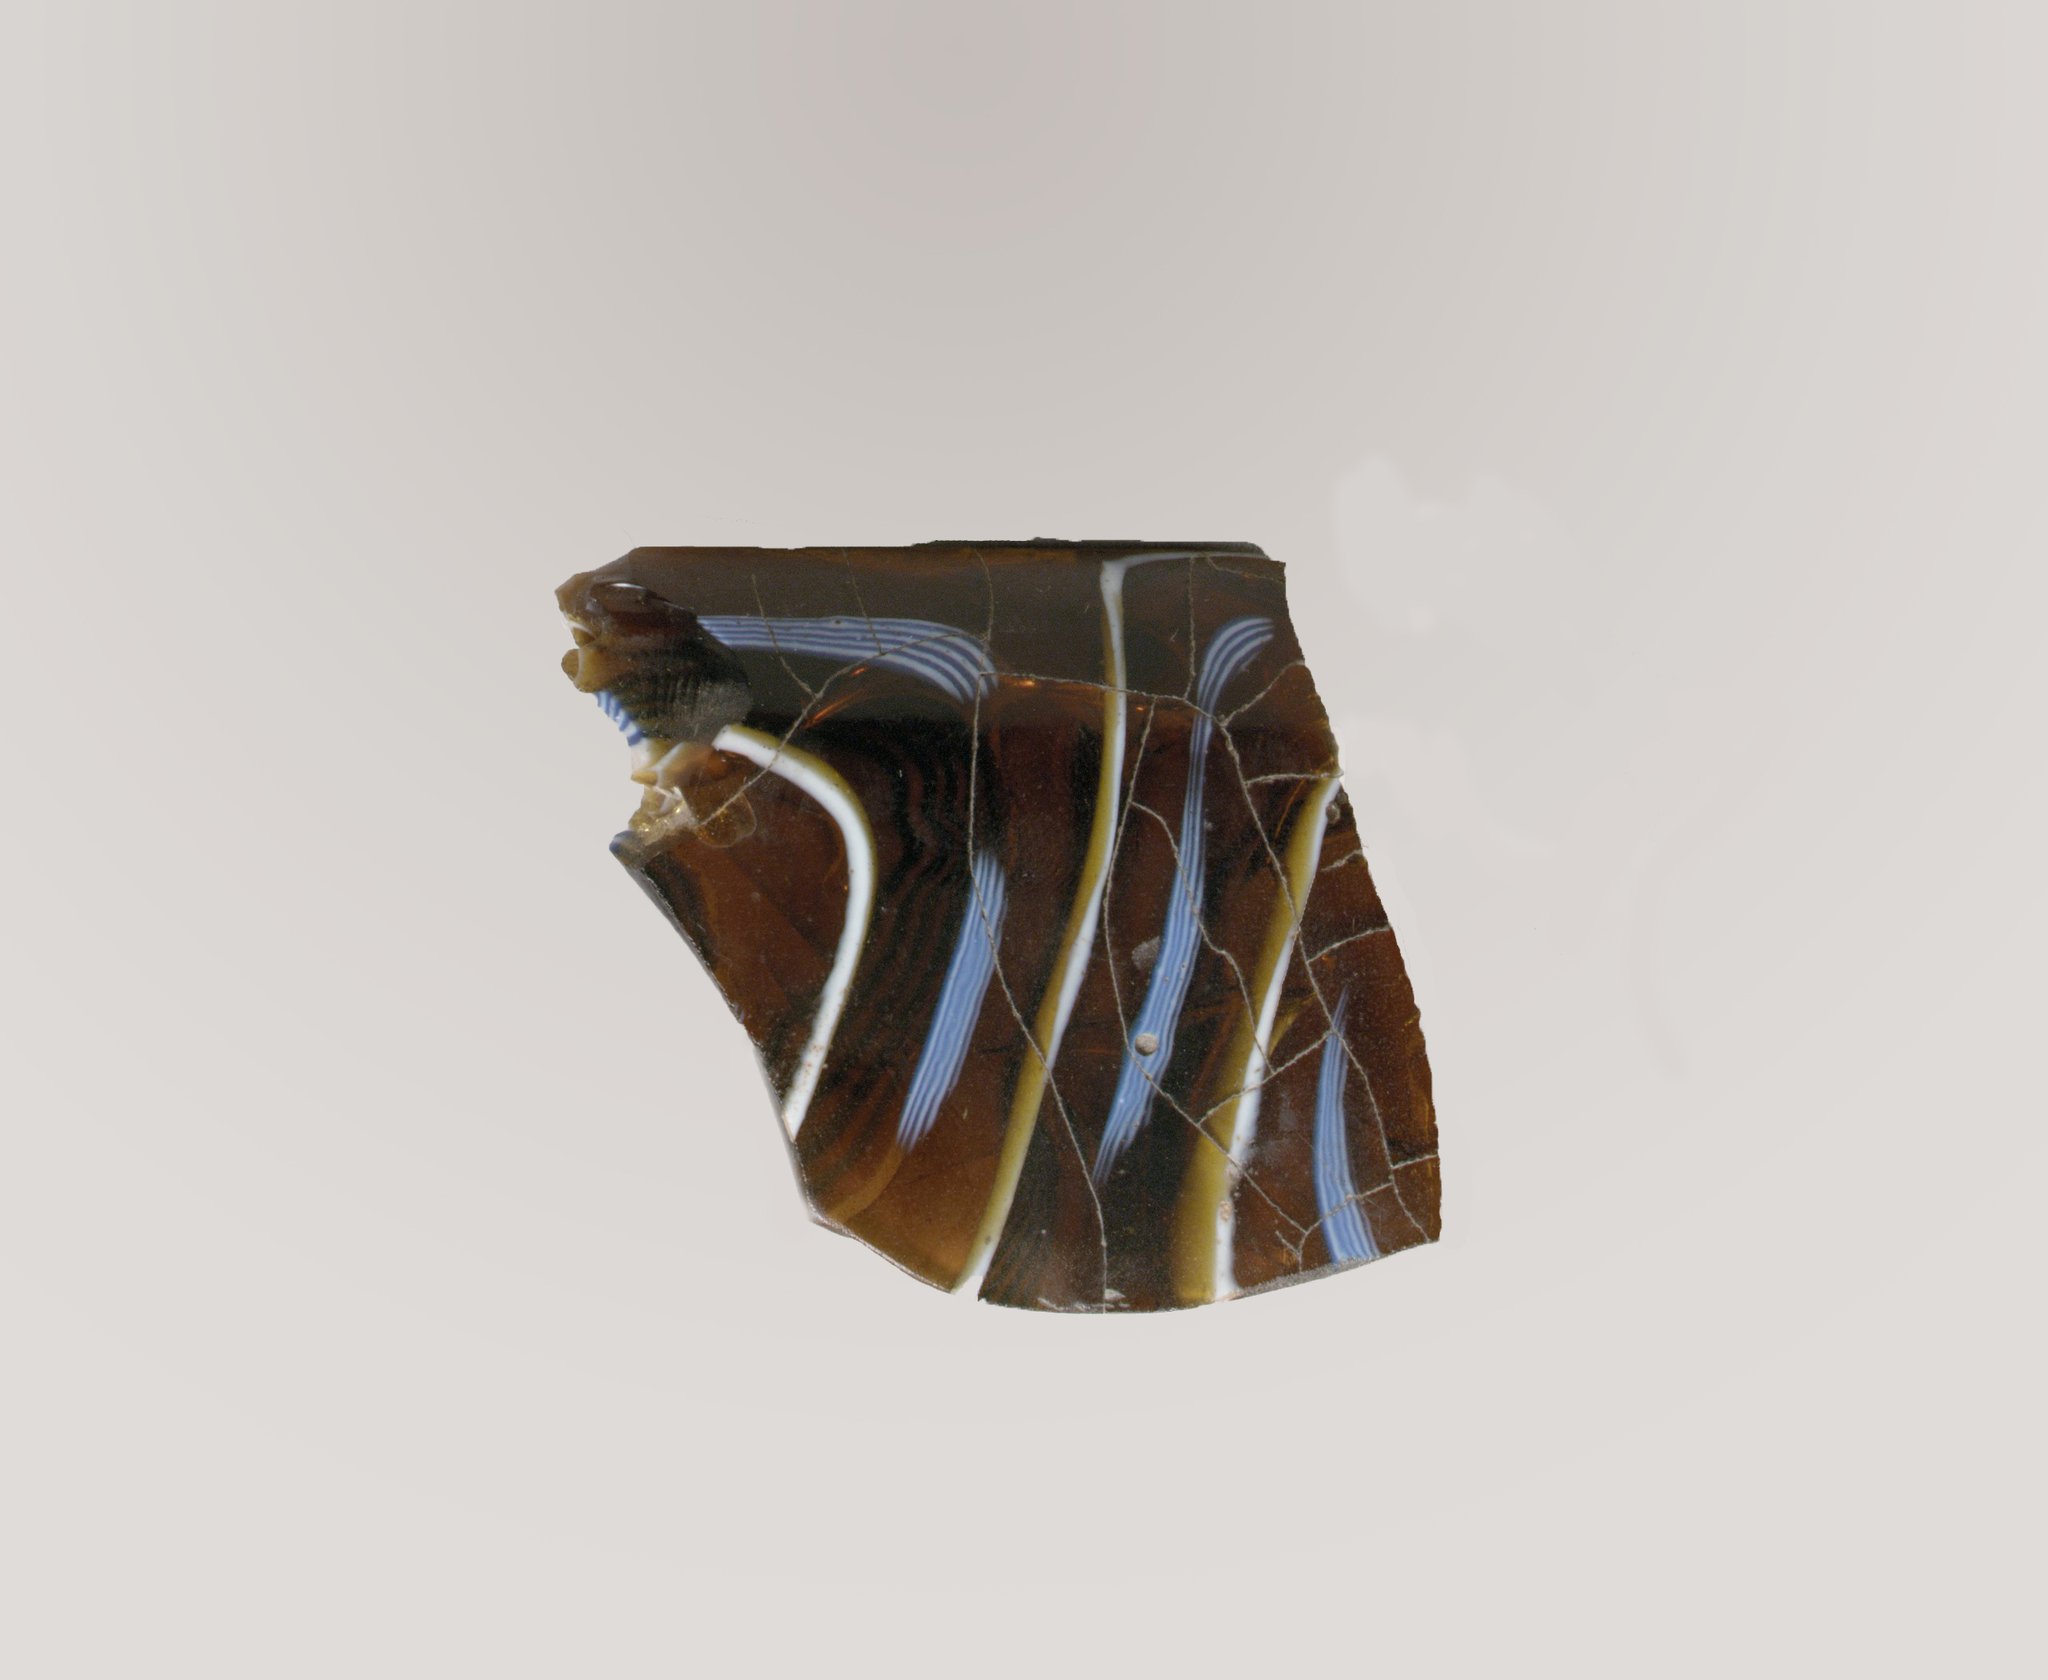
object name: fragment, mosaic bowl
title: Glass mosaic ribbed bowl fragment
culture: roman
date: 34 BCE-33 CE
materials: glass